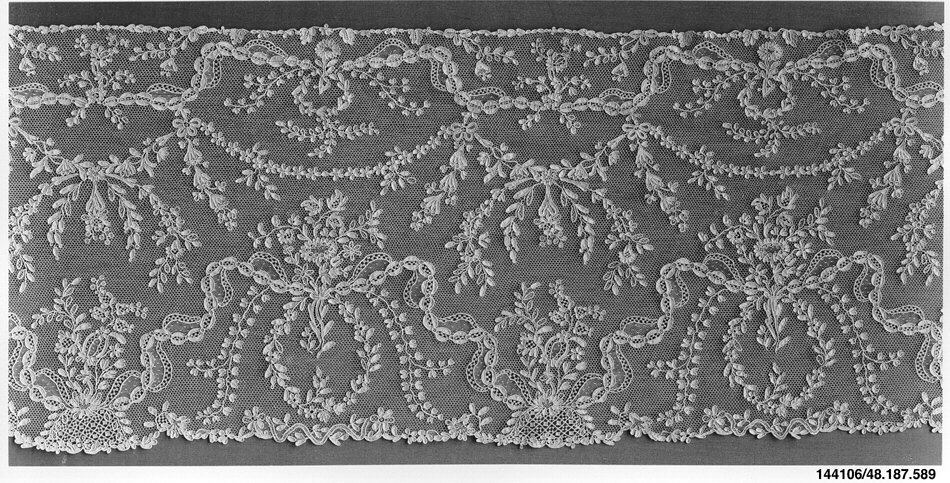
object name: flounce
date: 1834-1866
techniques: lace